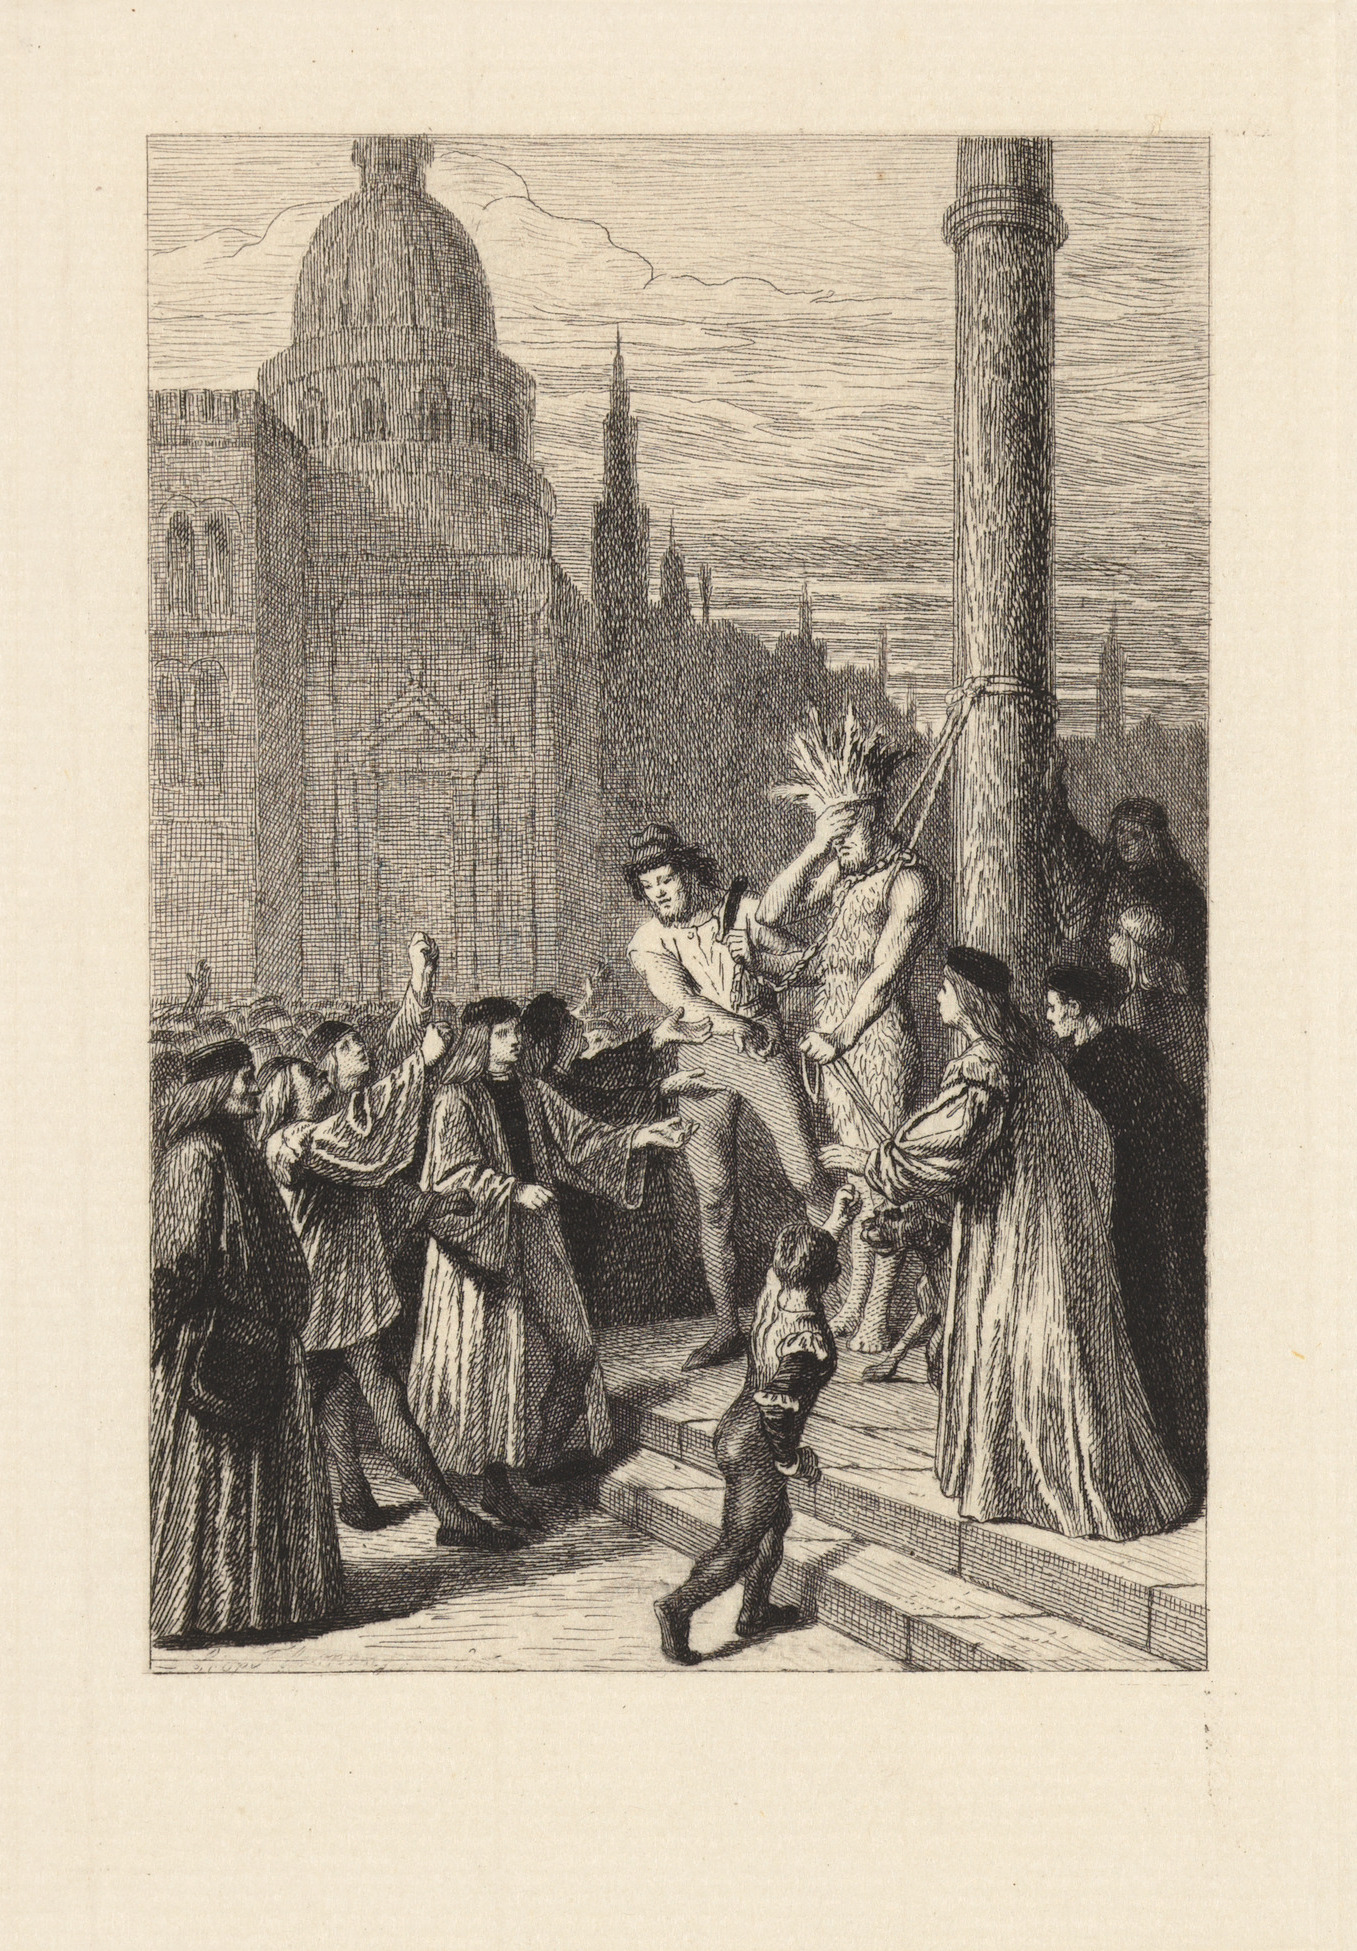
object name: print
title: Le Cordelier de Venise, plate 4 from "The Decameron"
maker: léopold flameng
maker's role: engraver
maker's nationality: french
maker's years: 1831-1911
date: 1873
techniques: etching